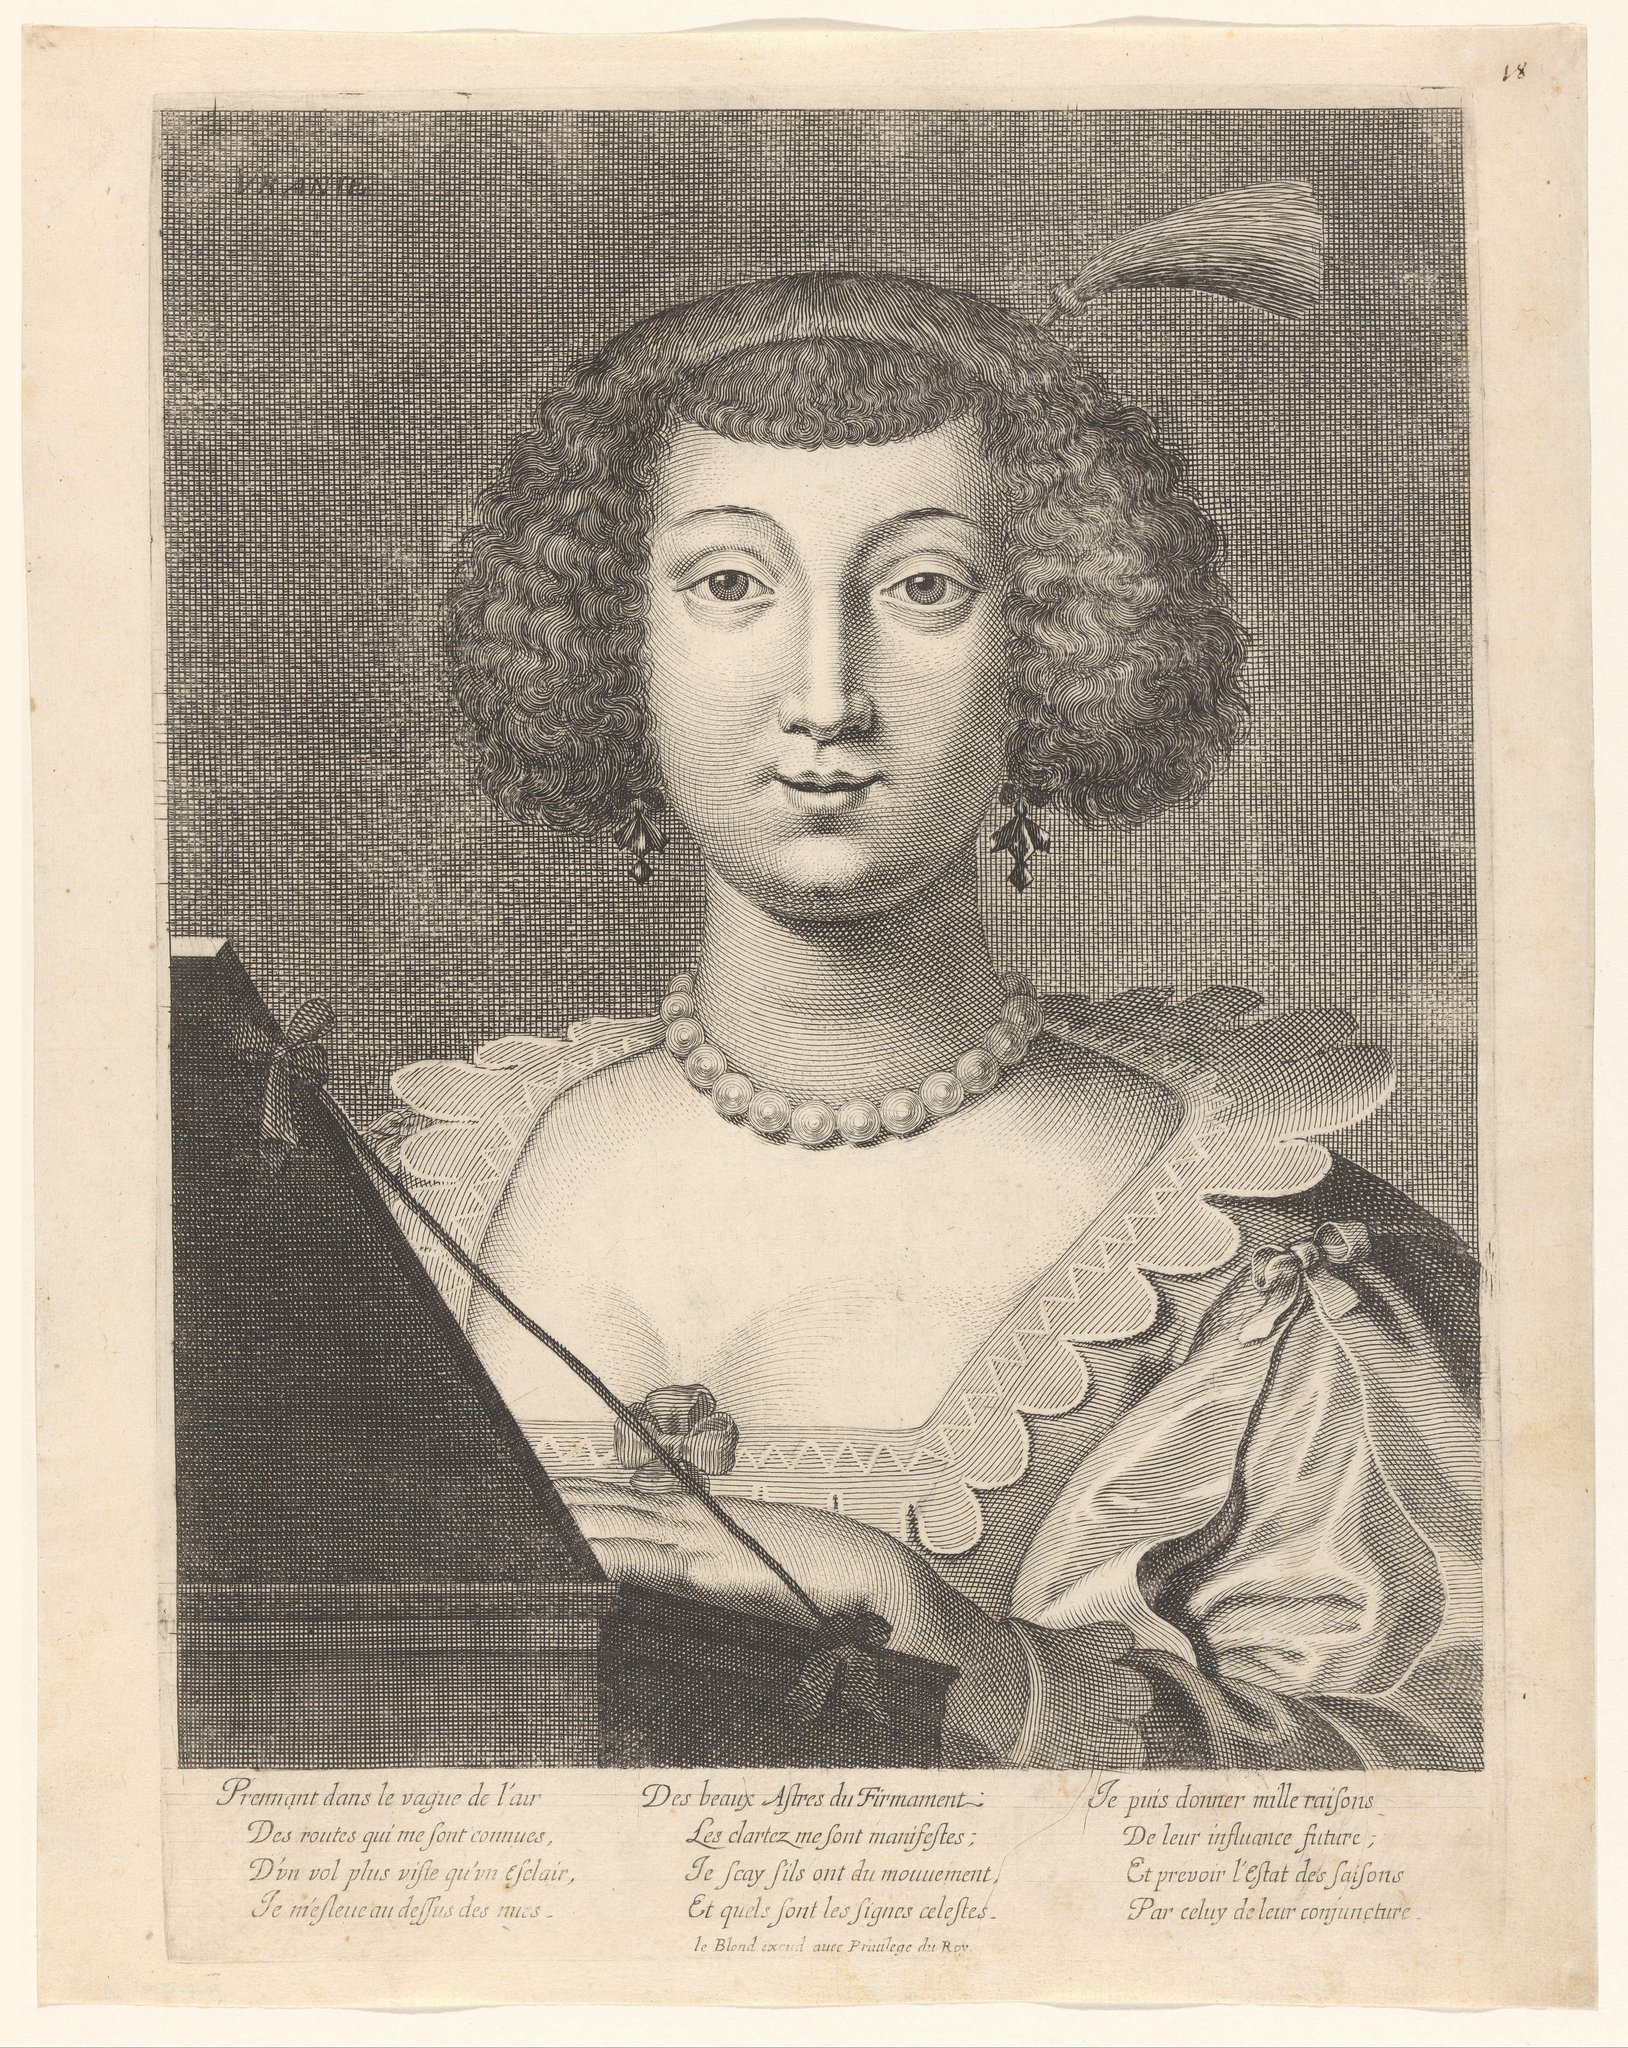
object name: print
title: Apollo and the Nine Muses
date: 1630-1635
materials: paper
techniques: engraving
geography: france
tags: one person playing keyboard instrument, clavichord, harpsichord, urania (one of the muses); 'urania' (ripa)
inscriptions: collector's mark: Lugt 2228, number: ‘18’, collector's mark: Lugt 2760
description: While there are numerous depictions of Apollo and the nine muses, these ones are exceptional. In Greek mythology, Apollo is the god of music and harmony and his sisters, the muses, are the goddesses of art and science and symbols of inspiration. Le Blond portrayed each of them separately, making music. Dressed and coiffed according to the latest Parisian fashion around 1630, they have thus become contemporary.